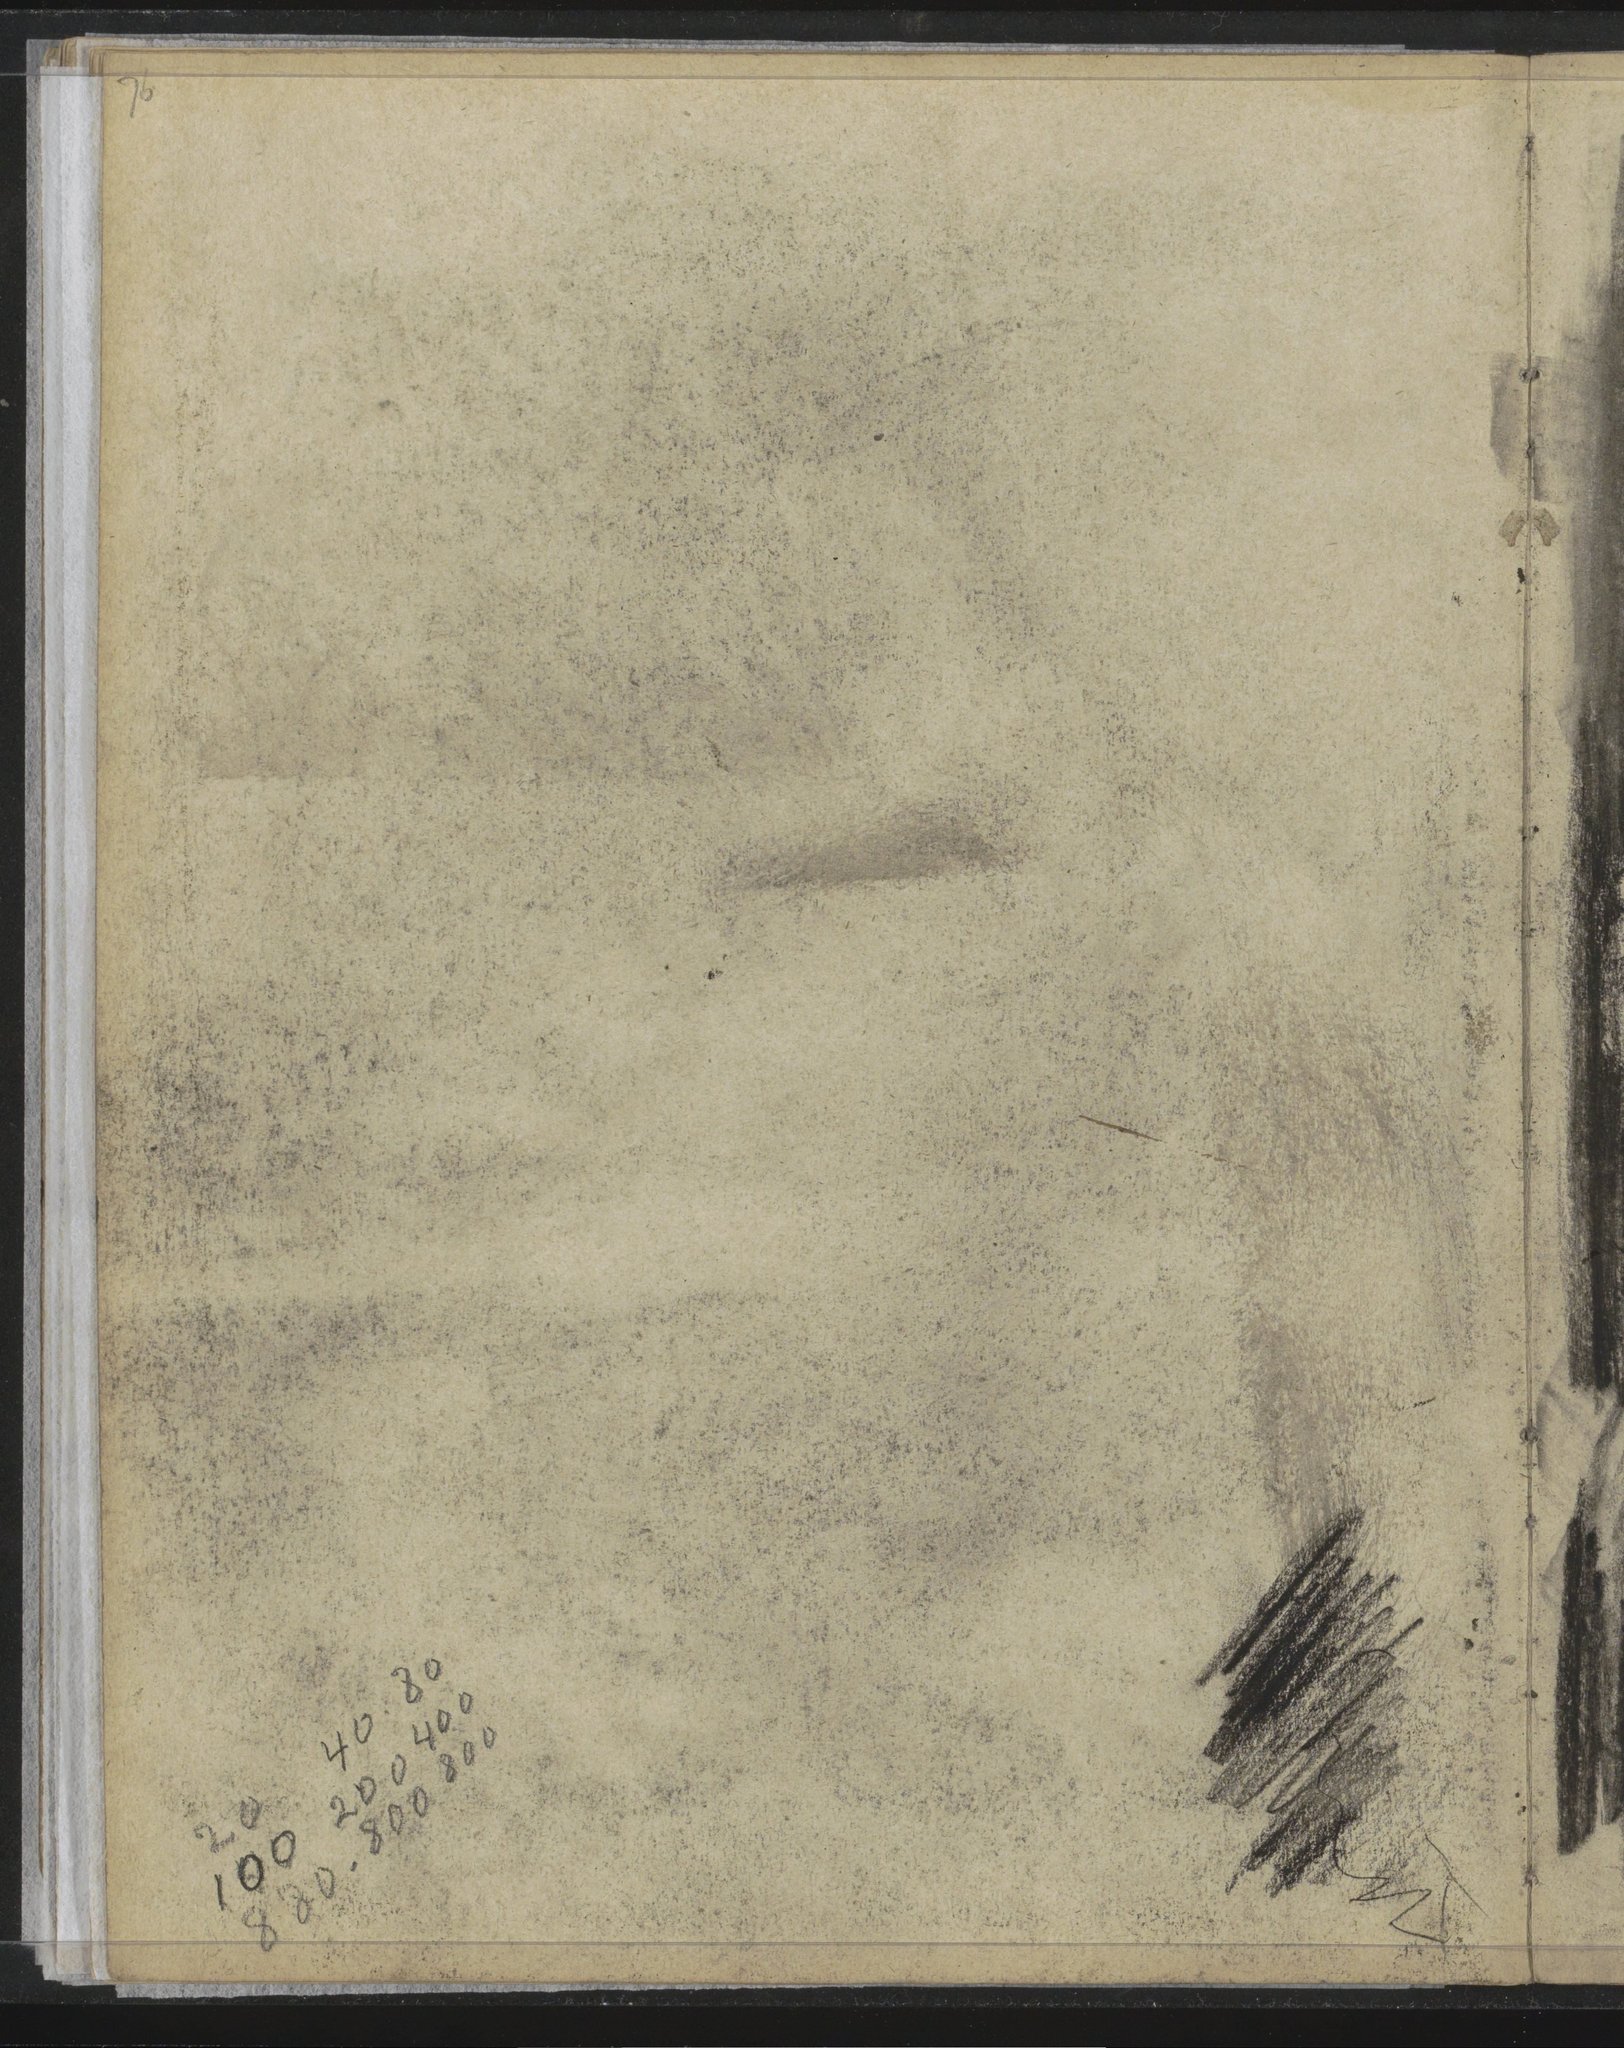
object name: sketchbook leaf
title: Getallen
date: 1887-1888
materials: chalk, paper, pencil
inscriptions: annotation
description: Pagina 76 uit een schetsboek met 43 bladen.